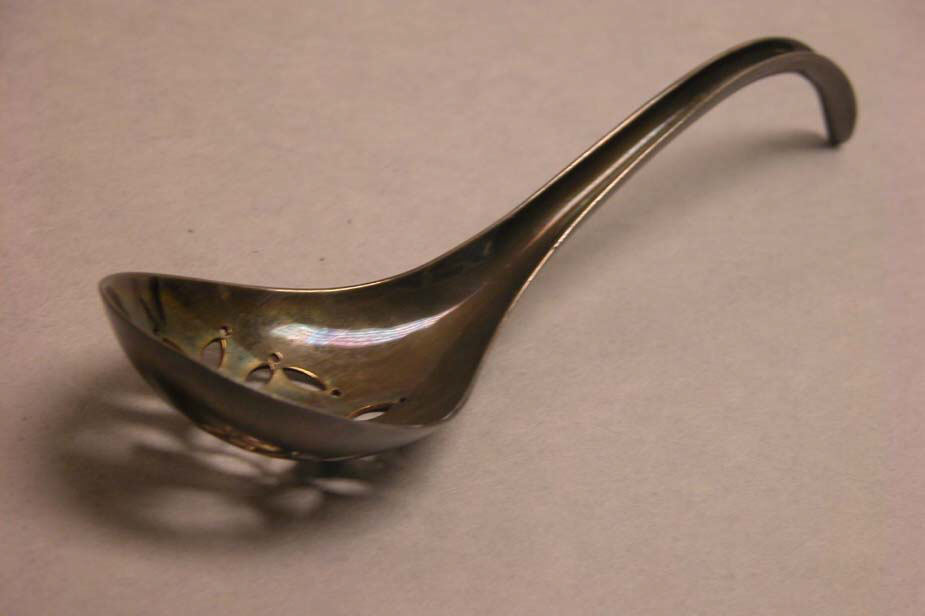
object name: sifter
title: Sugar Sifter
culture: japanese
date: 1801-1900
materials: silver